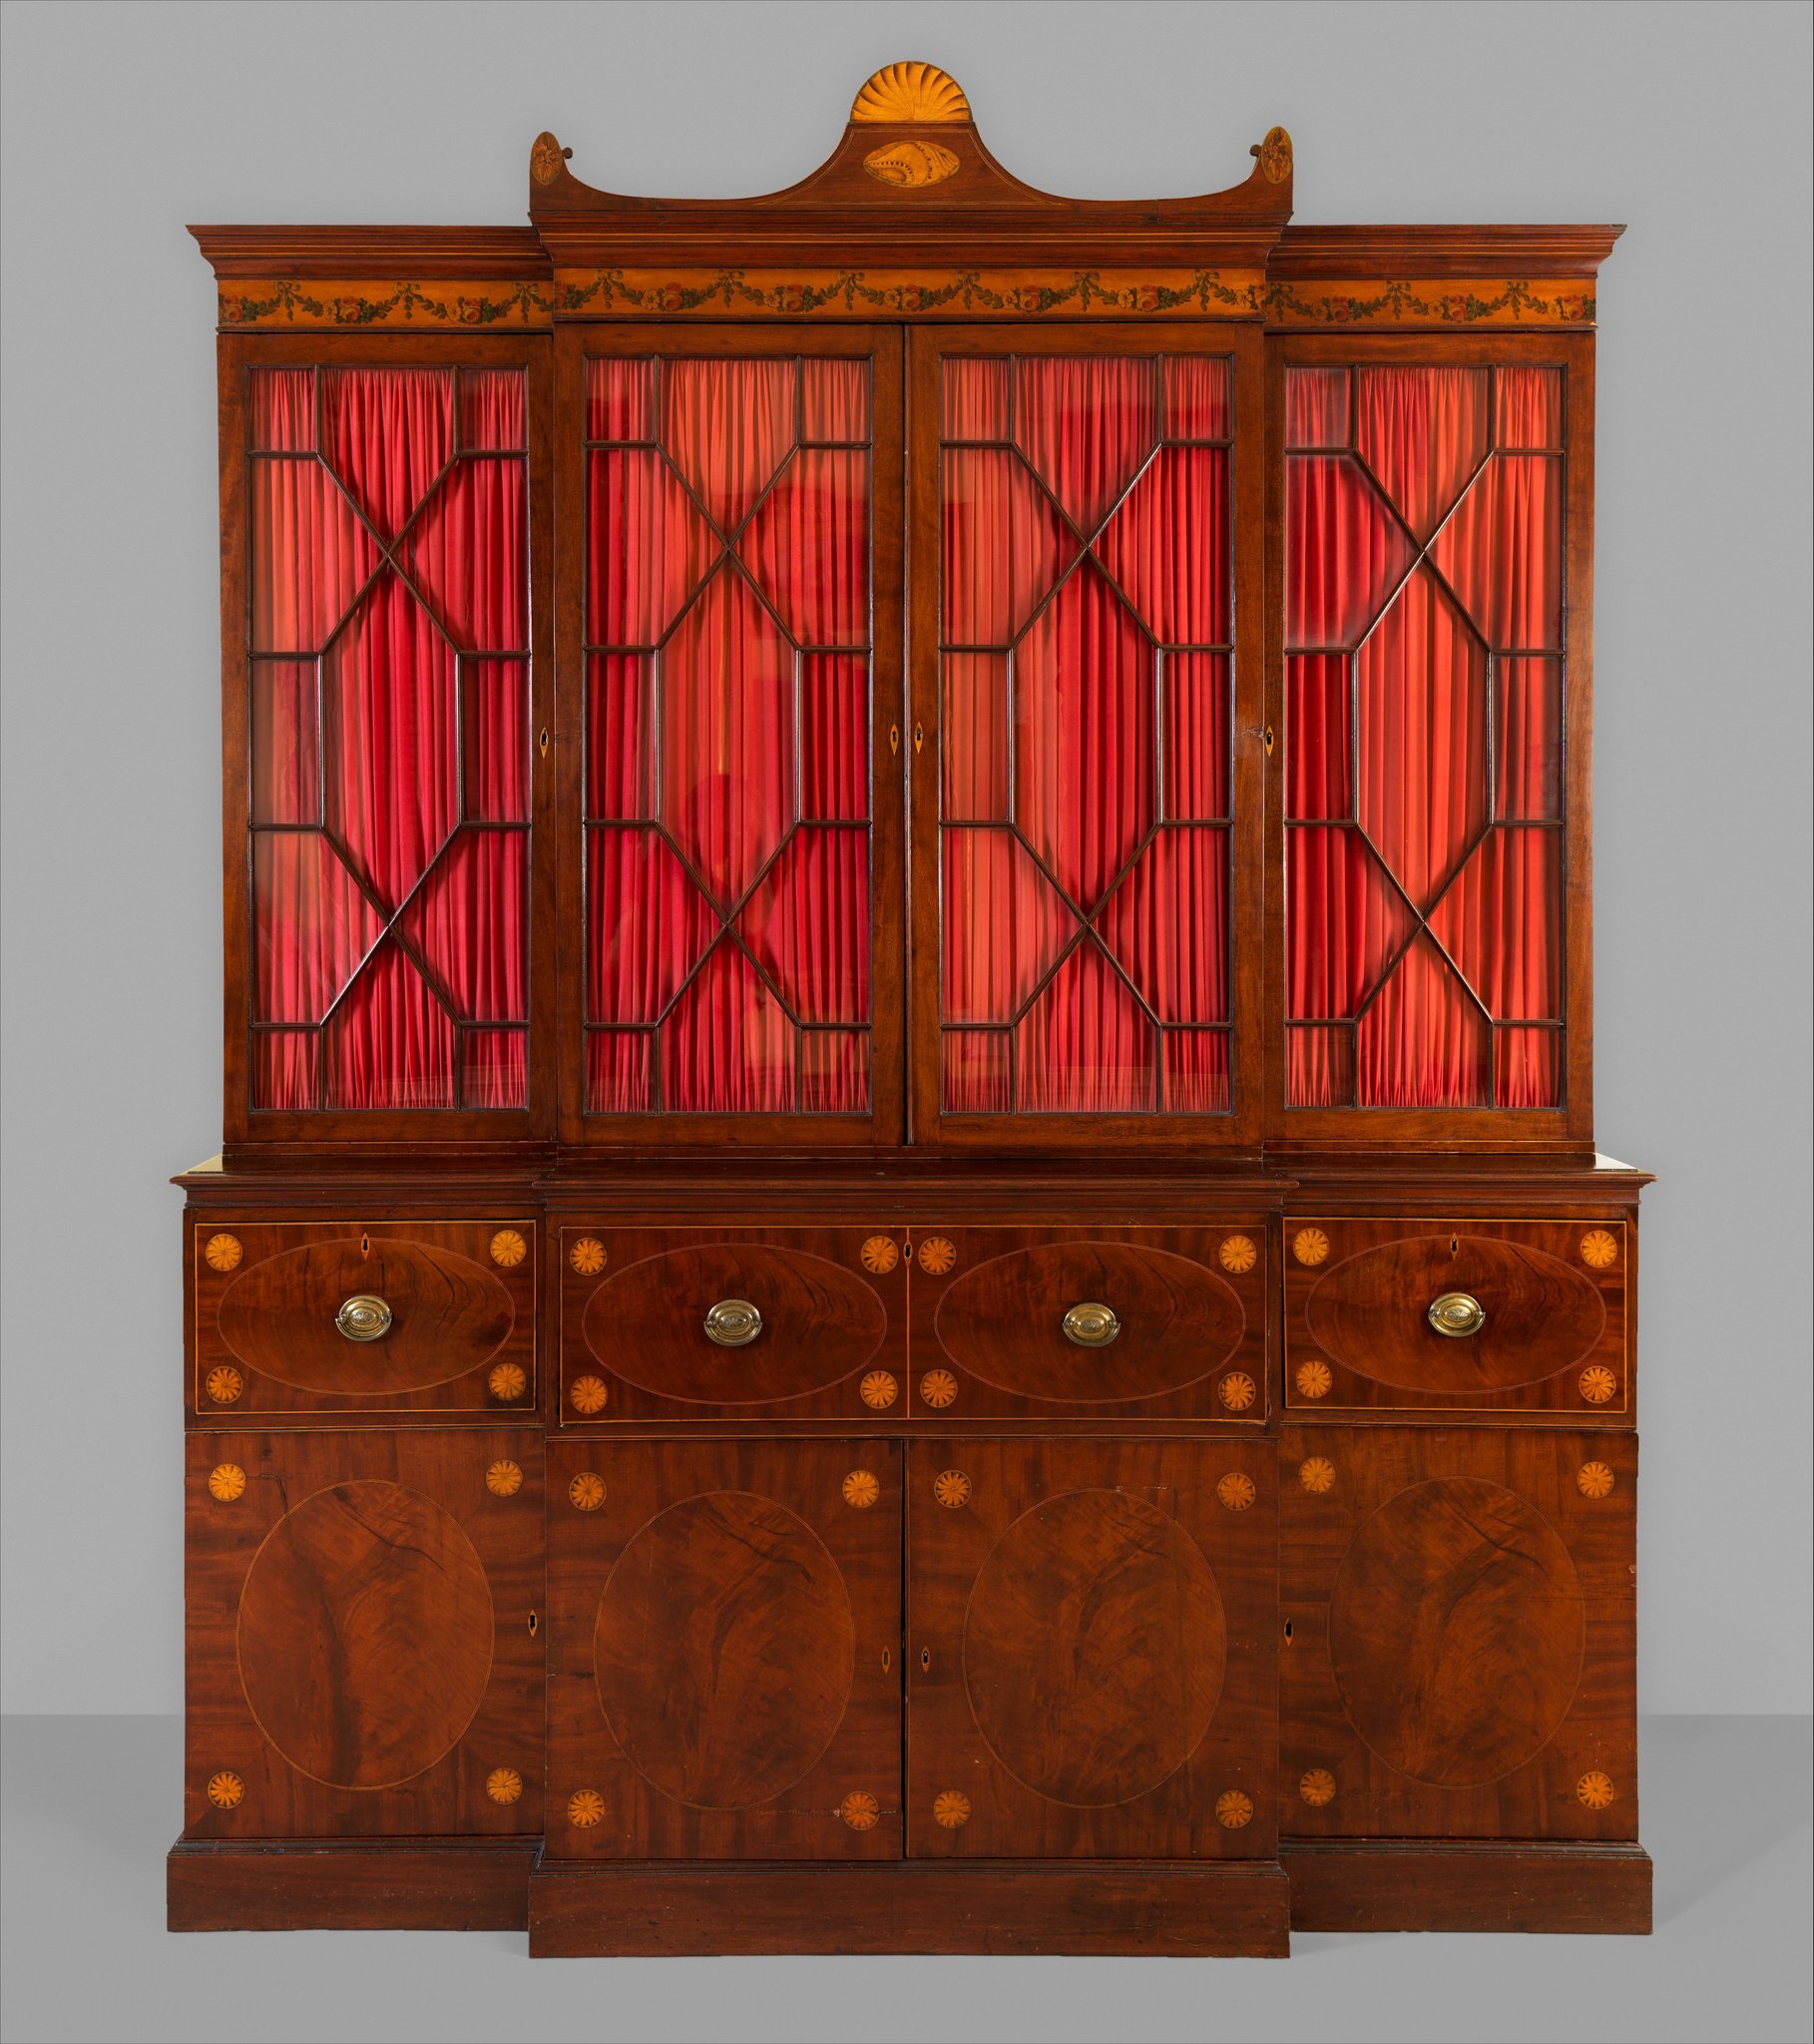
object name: secretary and bookcase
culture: american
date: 1795-1805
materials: wood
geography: united states